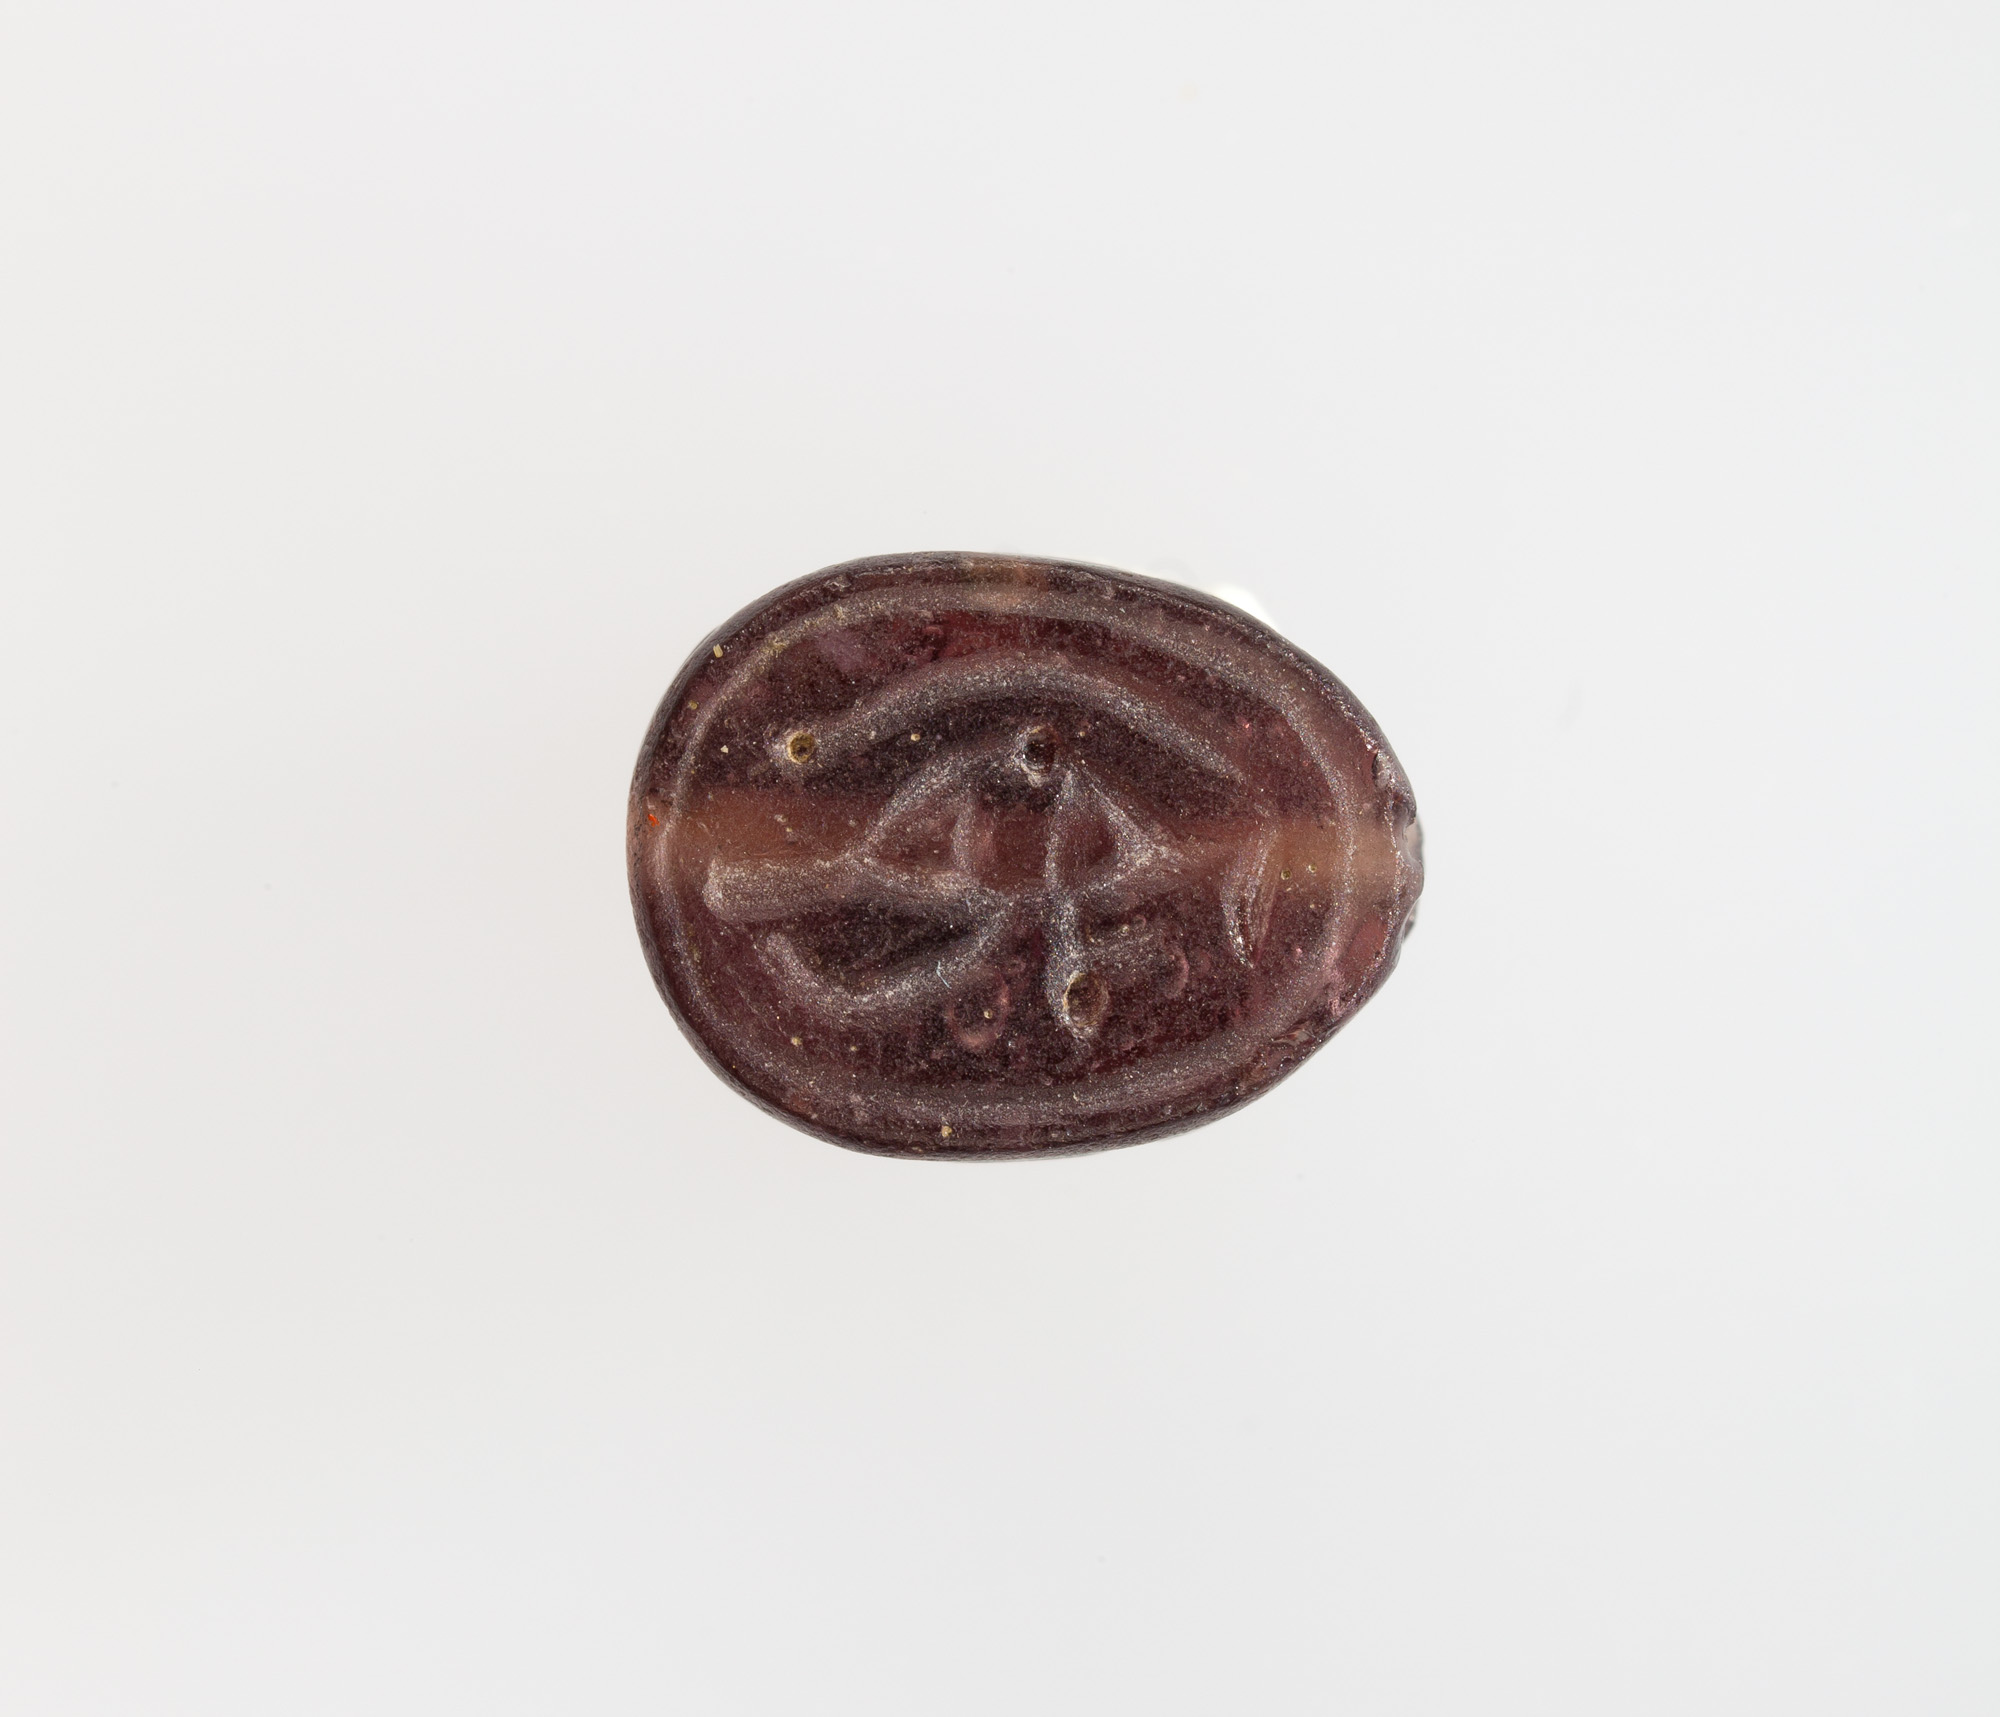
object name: scarab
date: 1479-1458 BCE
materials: faience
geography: egypt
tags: scarabs